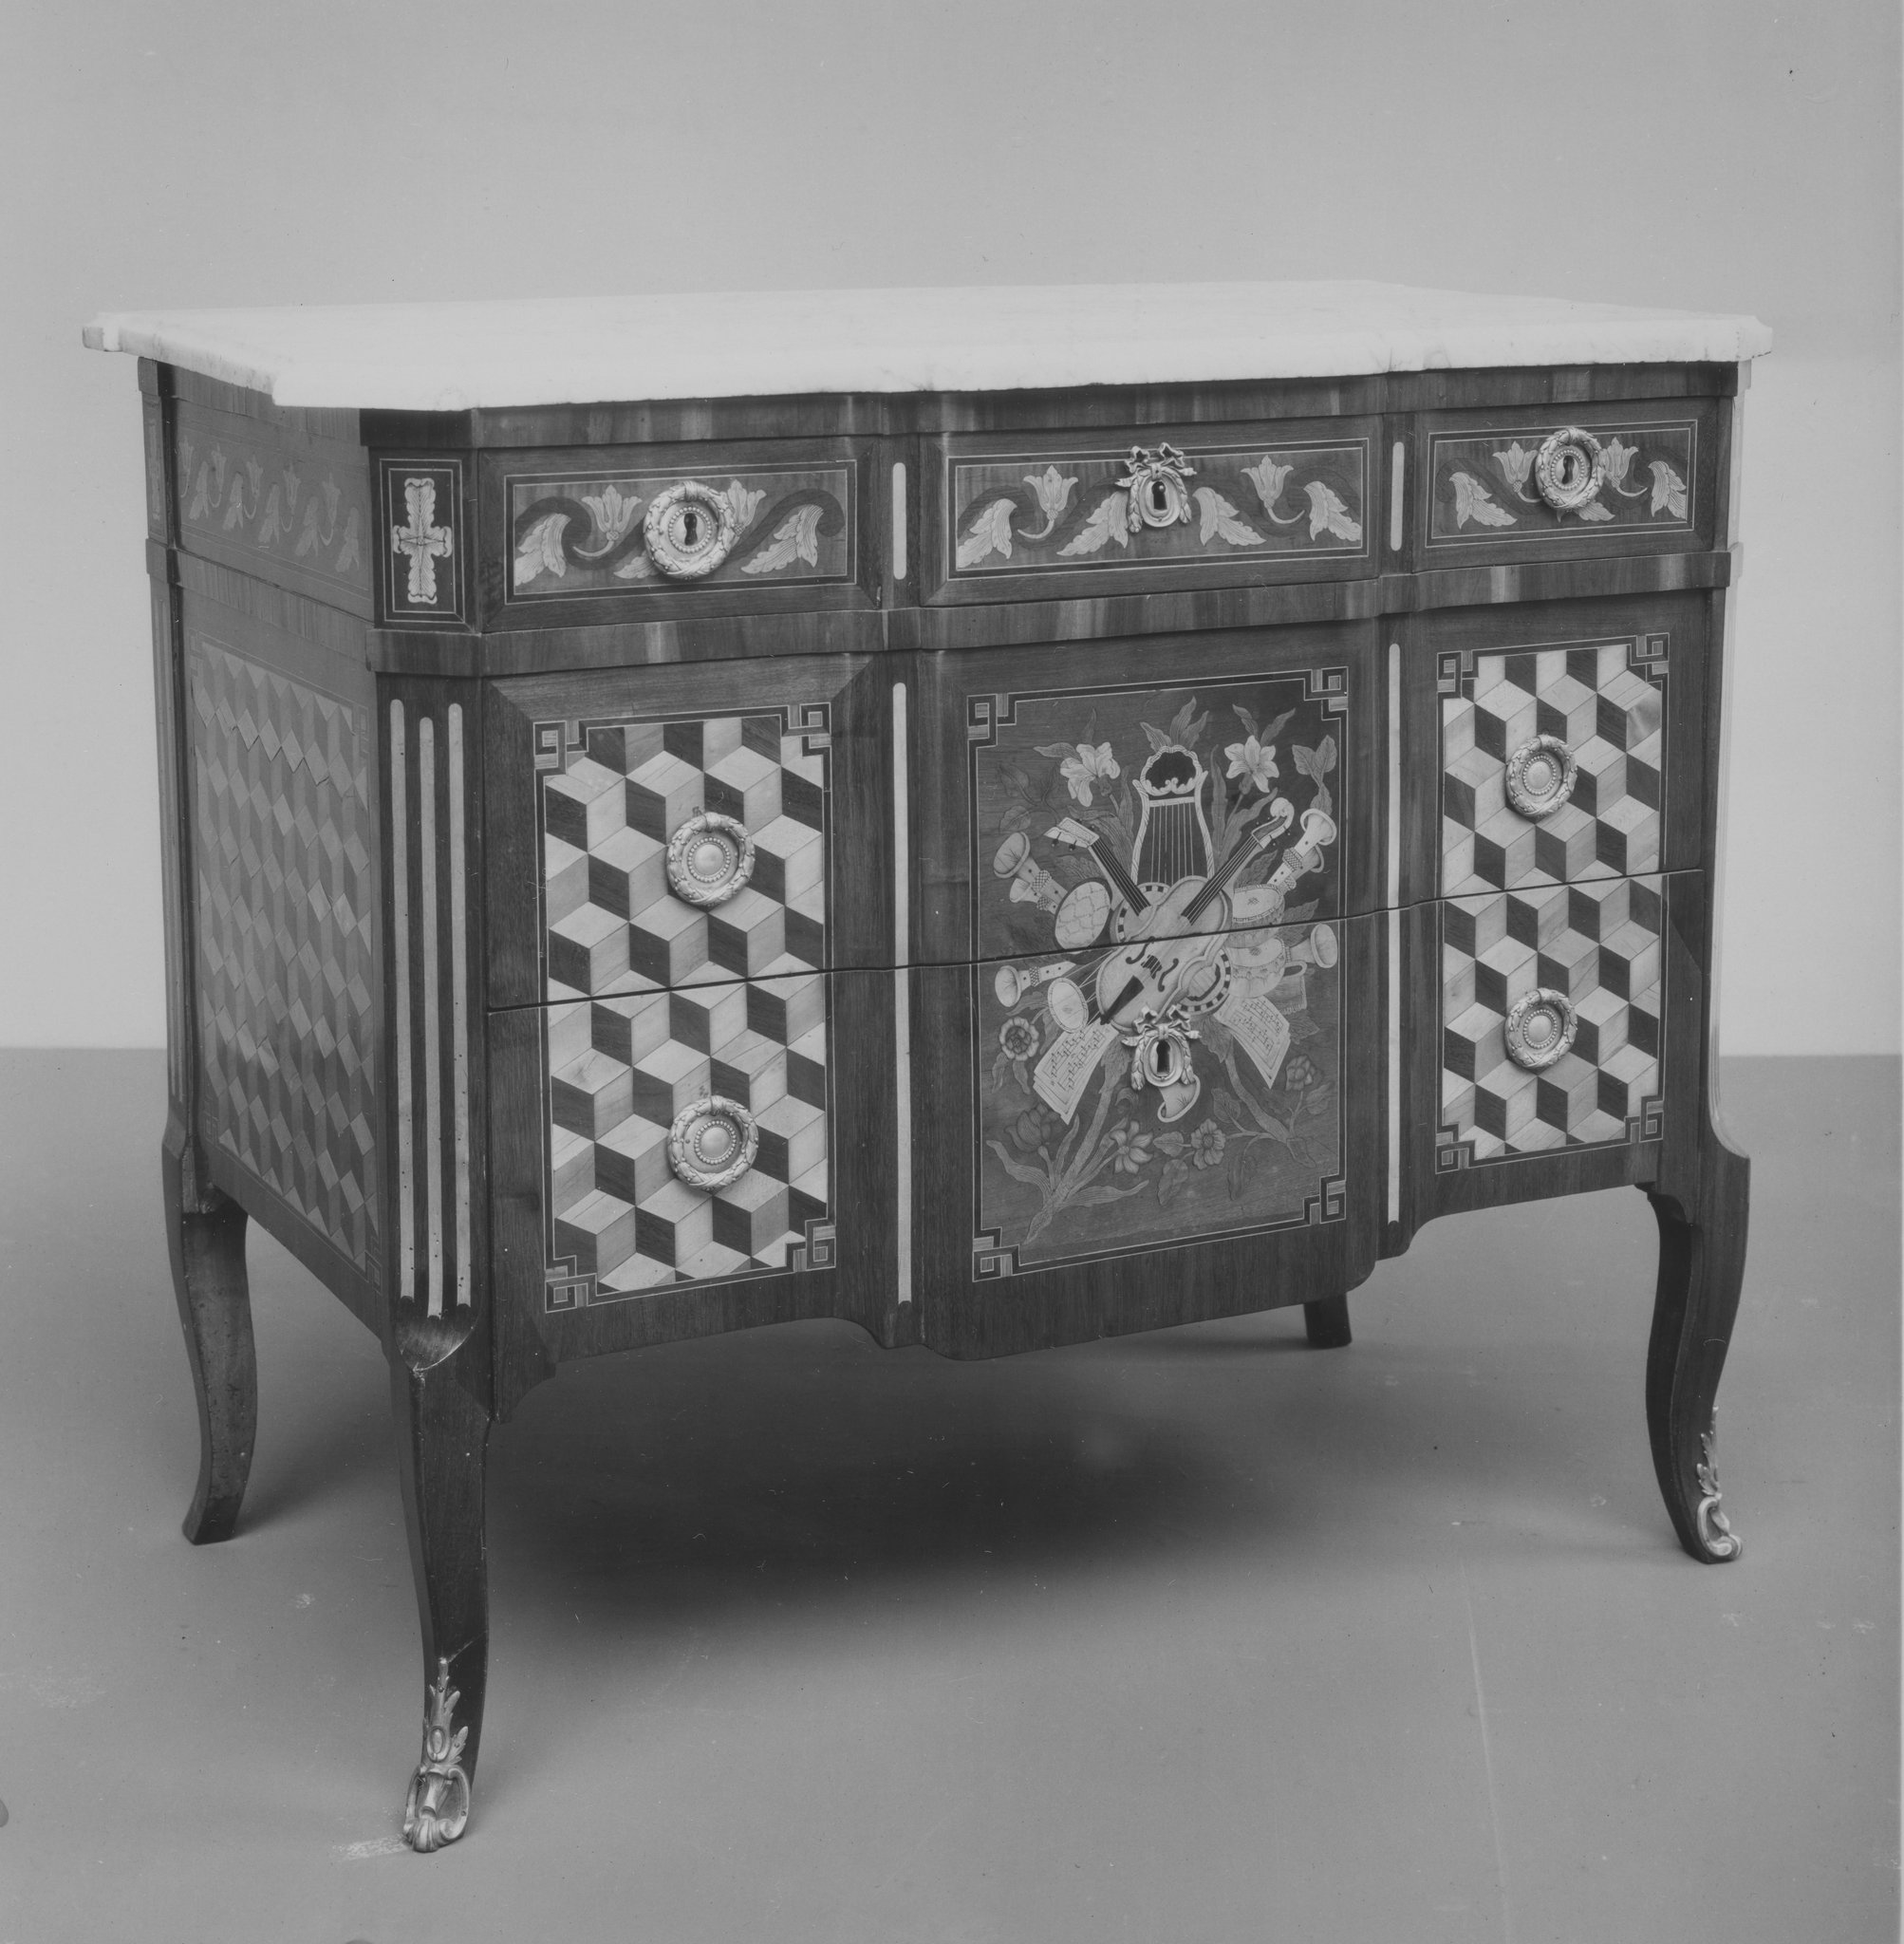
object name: commode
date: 1780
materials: gilt bronze, marble, wood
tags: musical instruments